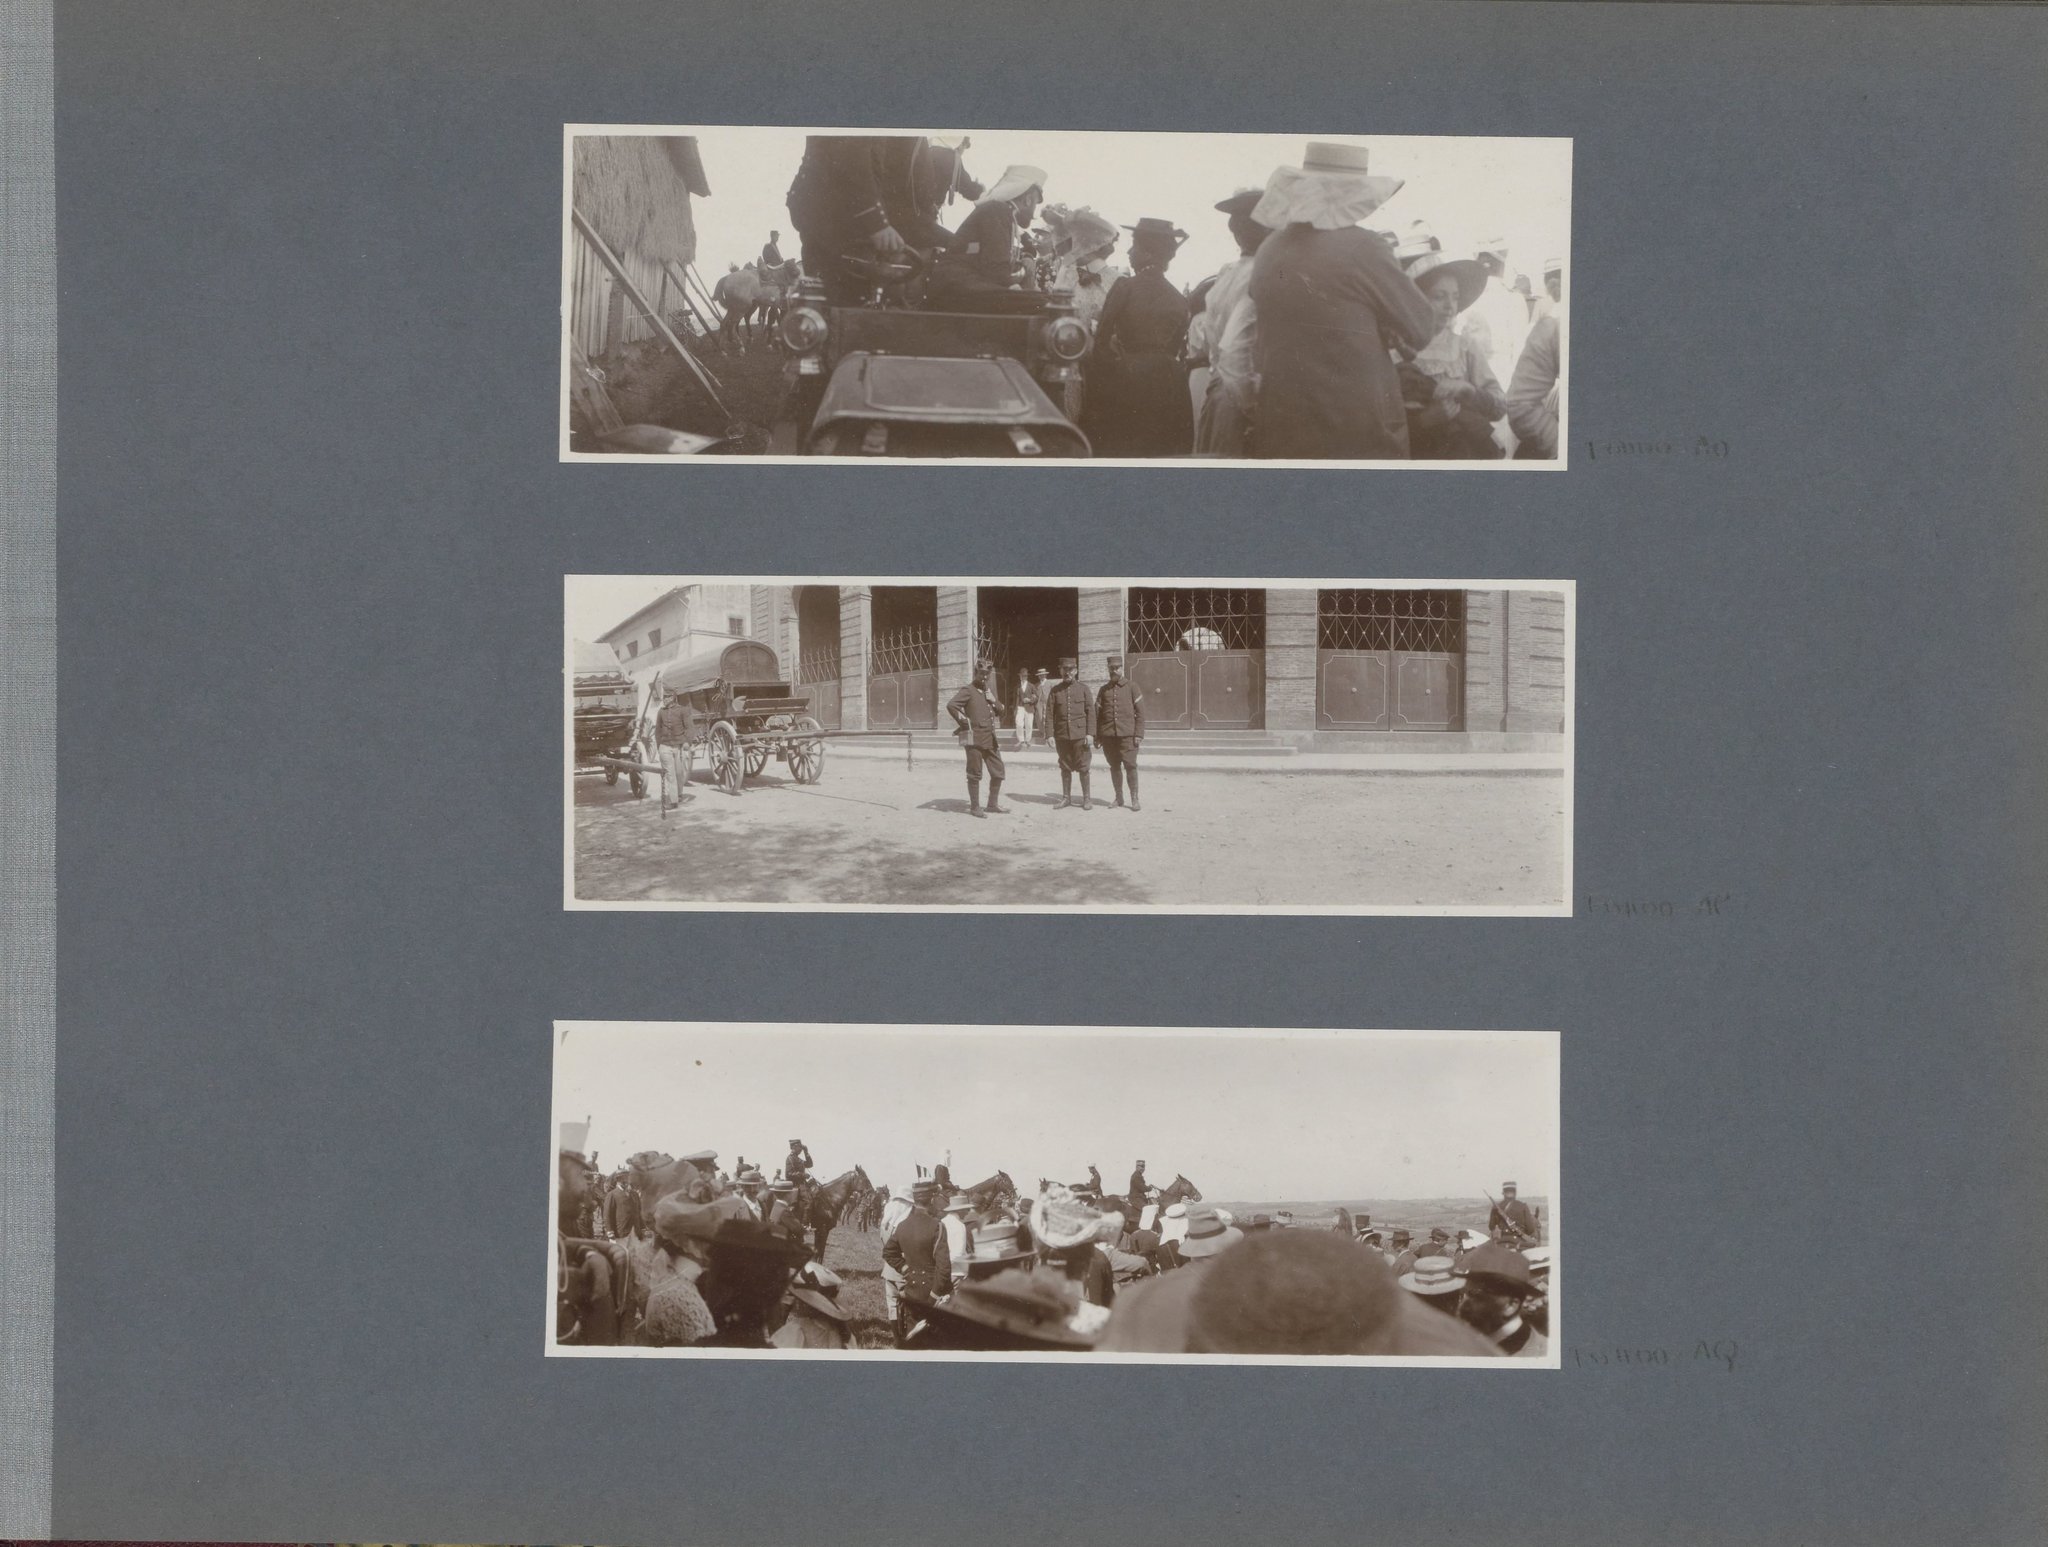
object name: album leaf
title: Militairen bij rijtuigen voor een gebouw in Frankrijk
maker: Anonymous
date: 1902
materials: paper, photographic support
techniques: daylight paper print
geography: france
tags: four-wheeled, animal-drawn vehicle, e.g.: cab, carriage, coach, france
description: Onderdeel van Fotoalbum van een legeroefening in Zuidwest-Frankrijk in 1902.